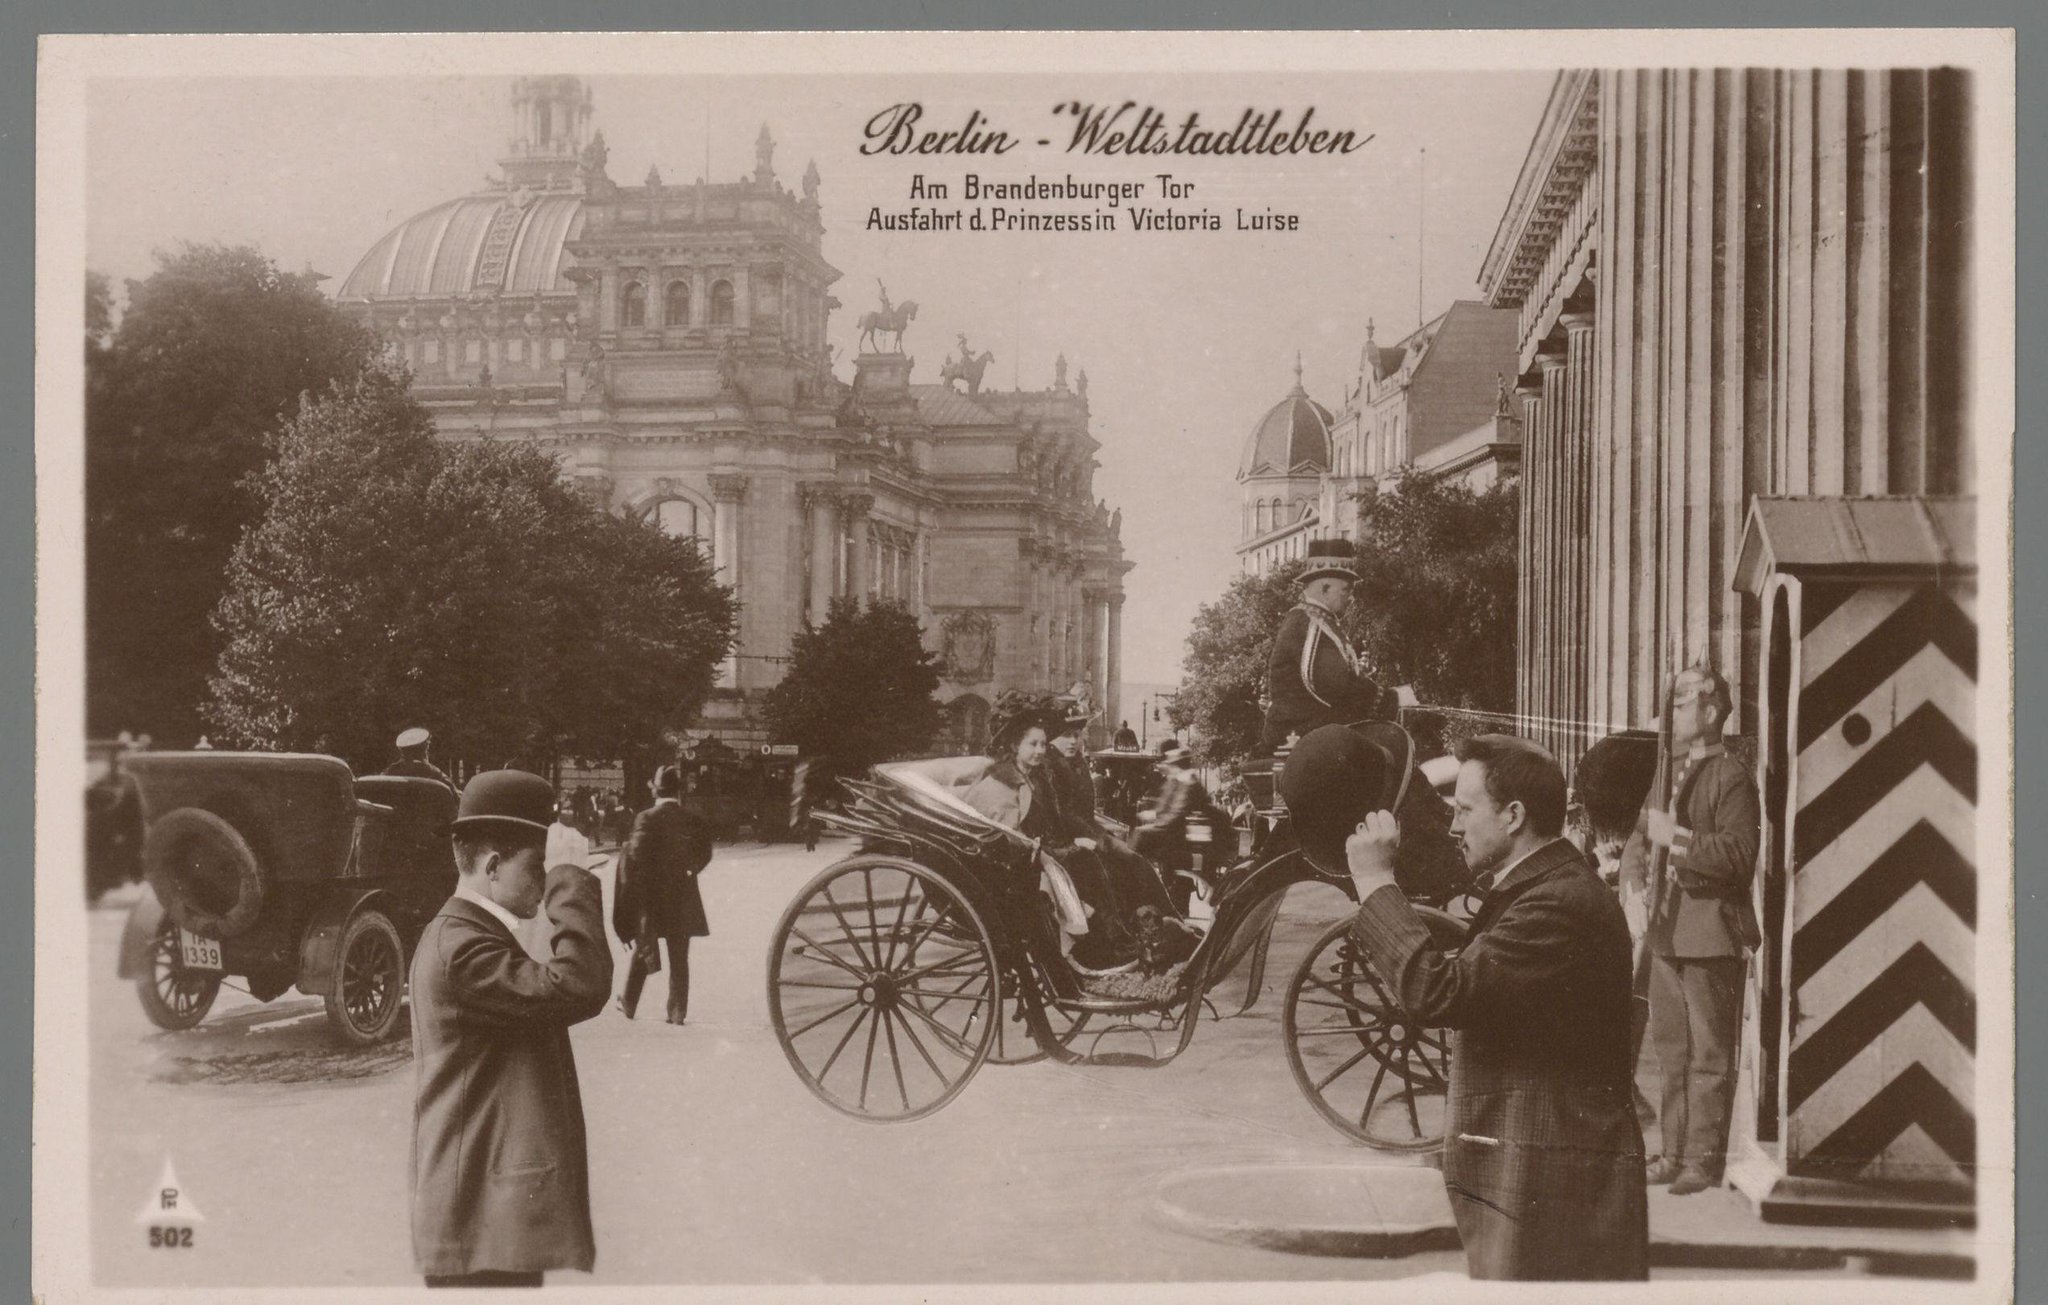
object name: photograph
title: Berlin Weltstadtleben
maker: p. hagelberg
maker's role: fotograaf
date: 1905-1930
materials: photographic support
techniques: photography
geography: berlin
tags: four-wheeled, animal-drawn vehicle, e.g.: cab, carriage, coach, princess, city-gate